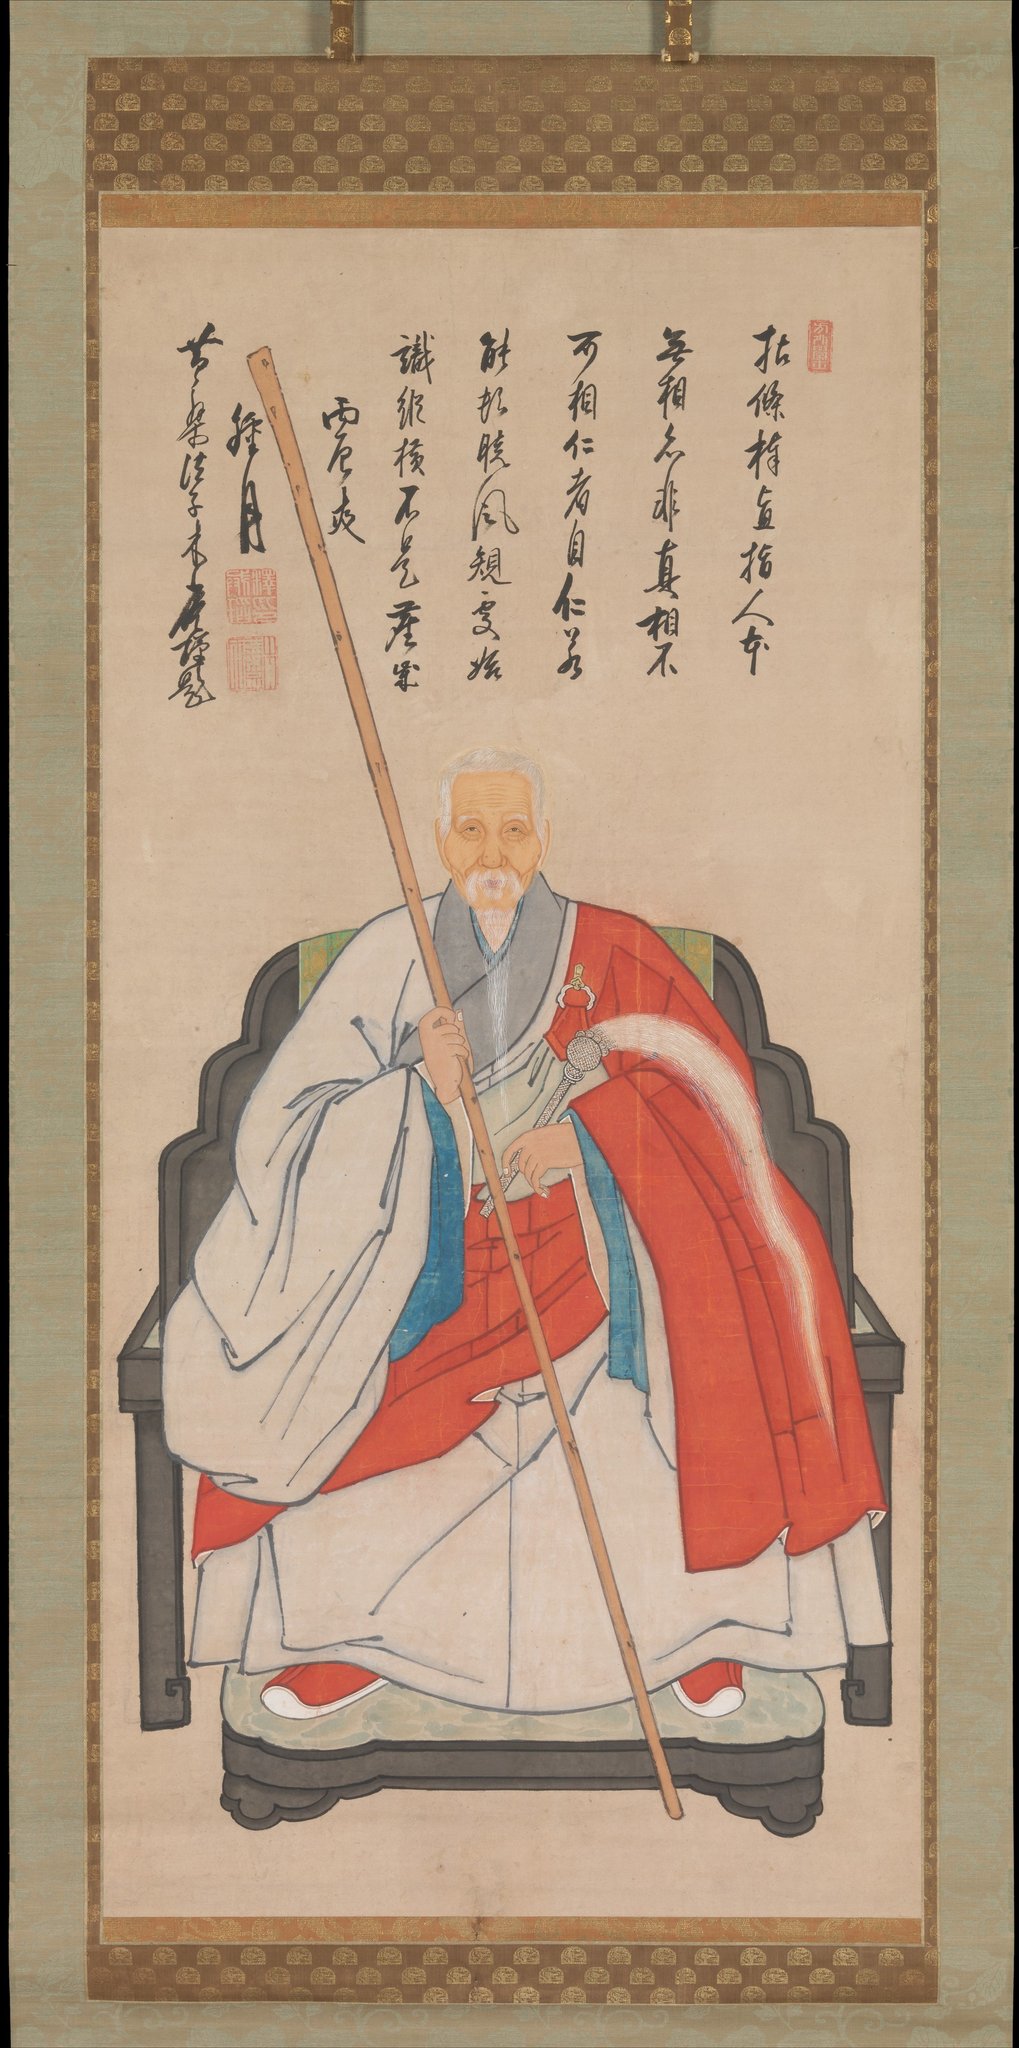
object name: hanging scroll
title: Portrait of Yinyuan Longqi (Ingen Ryūki)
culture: japanese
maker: unidentified artist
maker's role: artist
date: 1676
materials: ink, paper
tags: men,portraits,poets